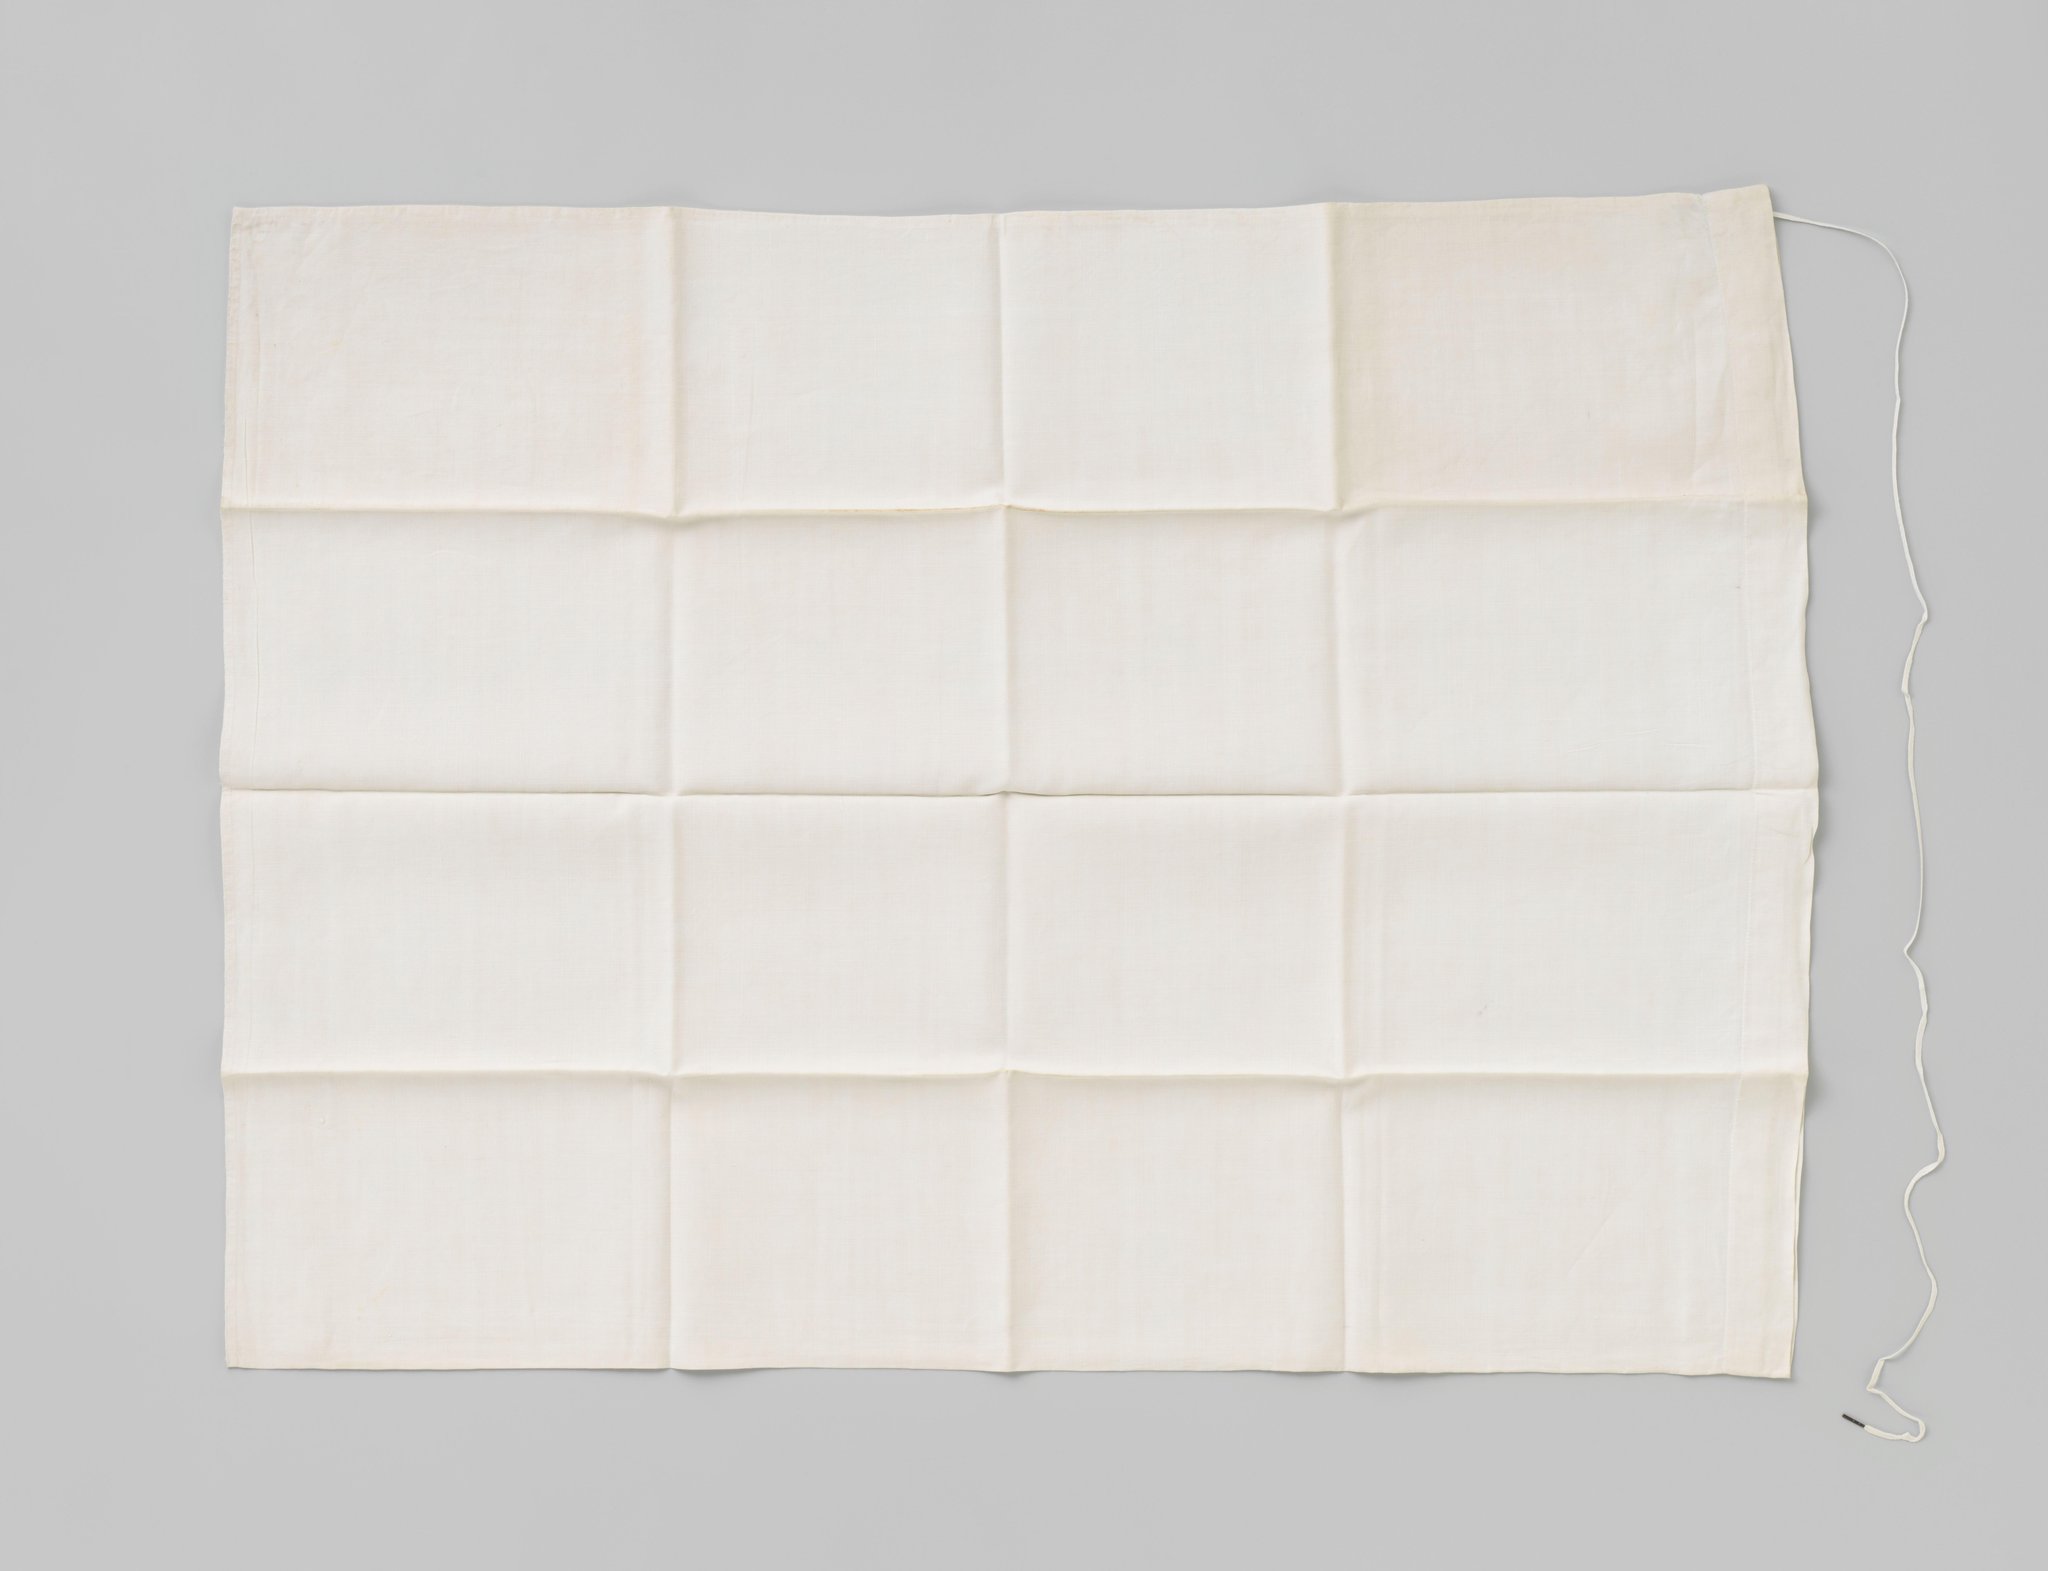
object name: sloop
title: Linnen kussensloop.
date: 1400-1950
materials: linen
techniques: weave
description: Linnen kussensloop. Bij het sloop hoort een kussensloop met invnr. BK-1980-637-A.